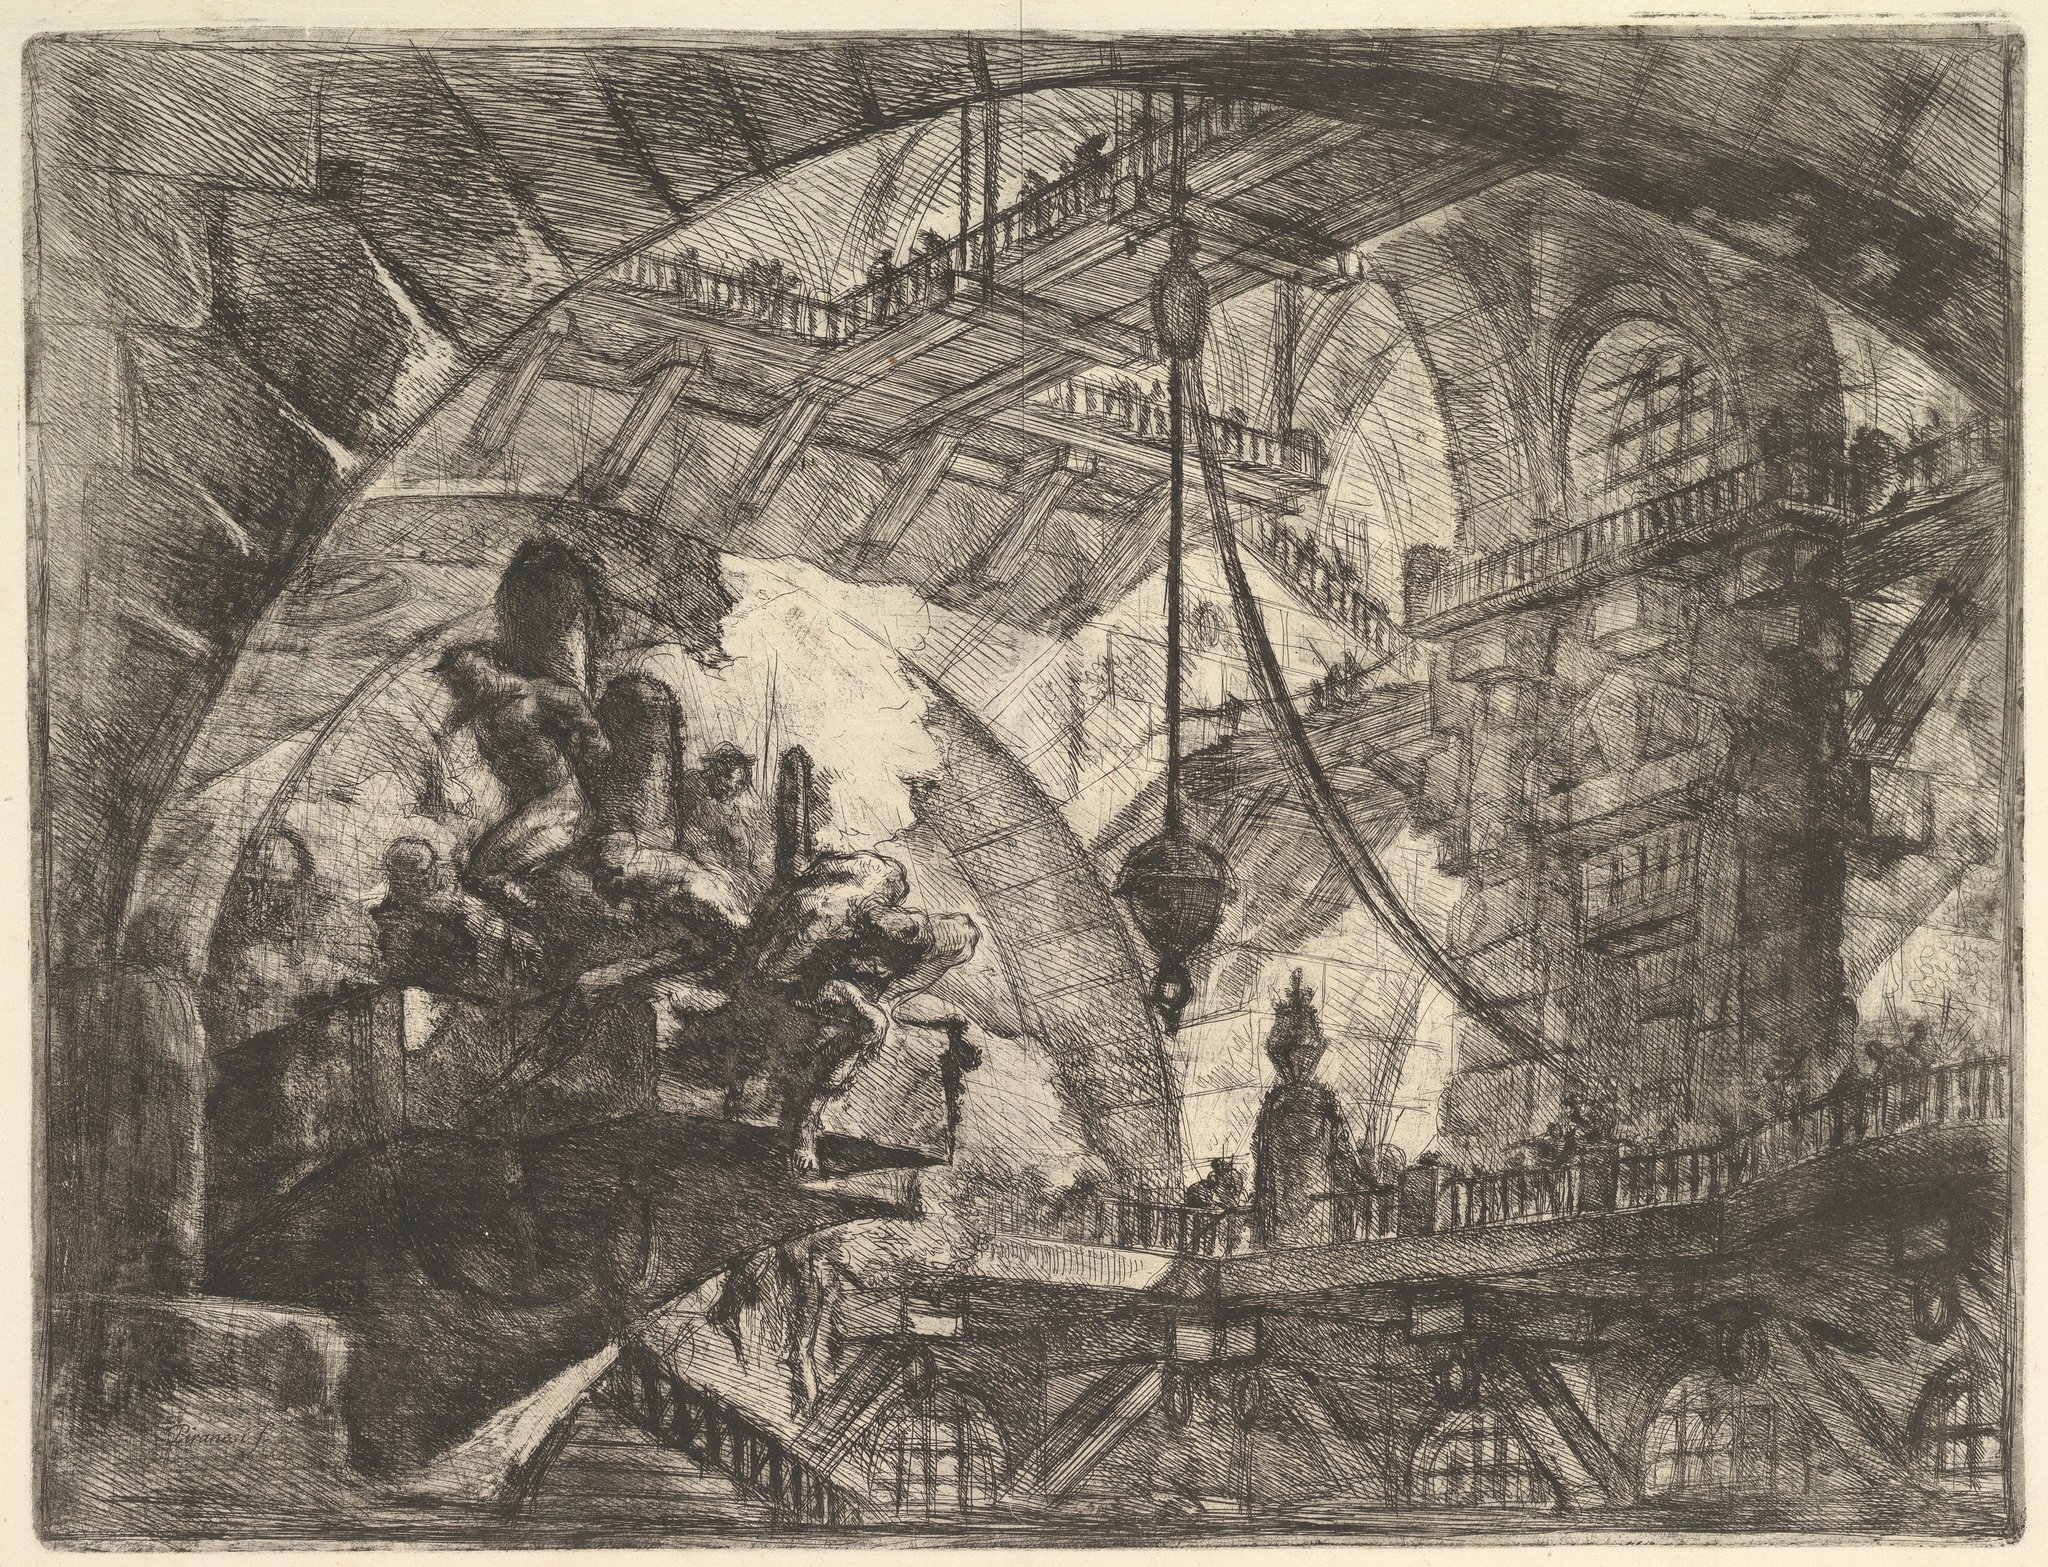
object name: print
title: Prisoners on a Projecting Platform, from "Carceri d'invenzione" (Imaginary Prisons)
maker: giovanni battista piranesi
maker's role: artist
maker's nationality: italian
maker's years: 1720-1778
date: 1749-1750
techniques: burnishing, engraving, etching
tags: human figures,prisoners